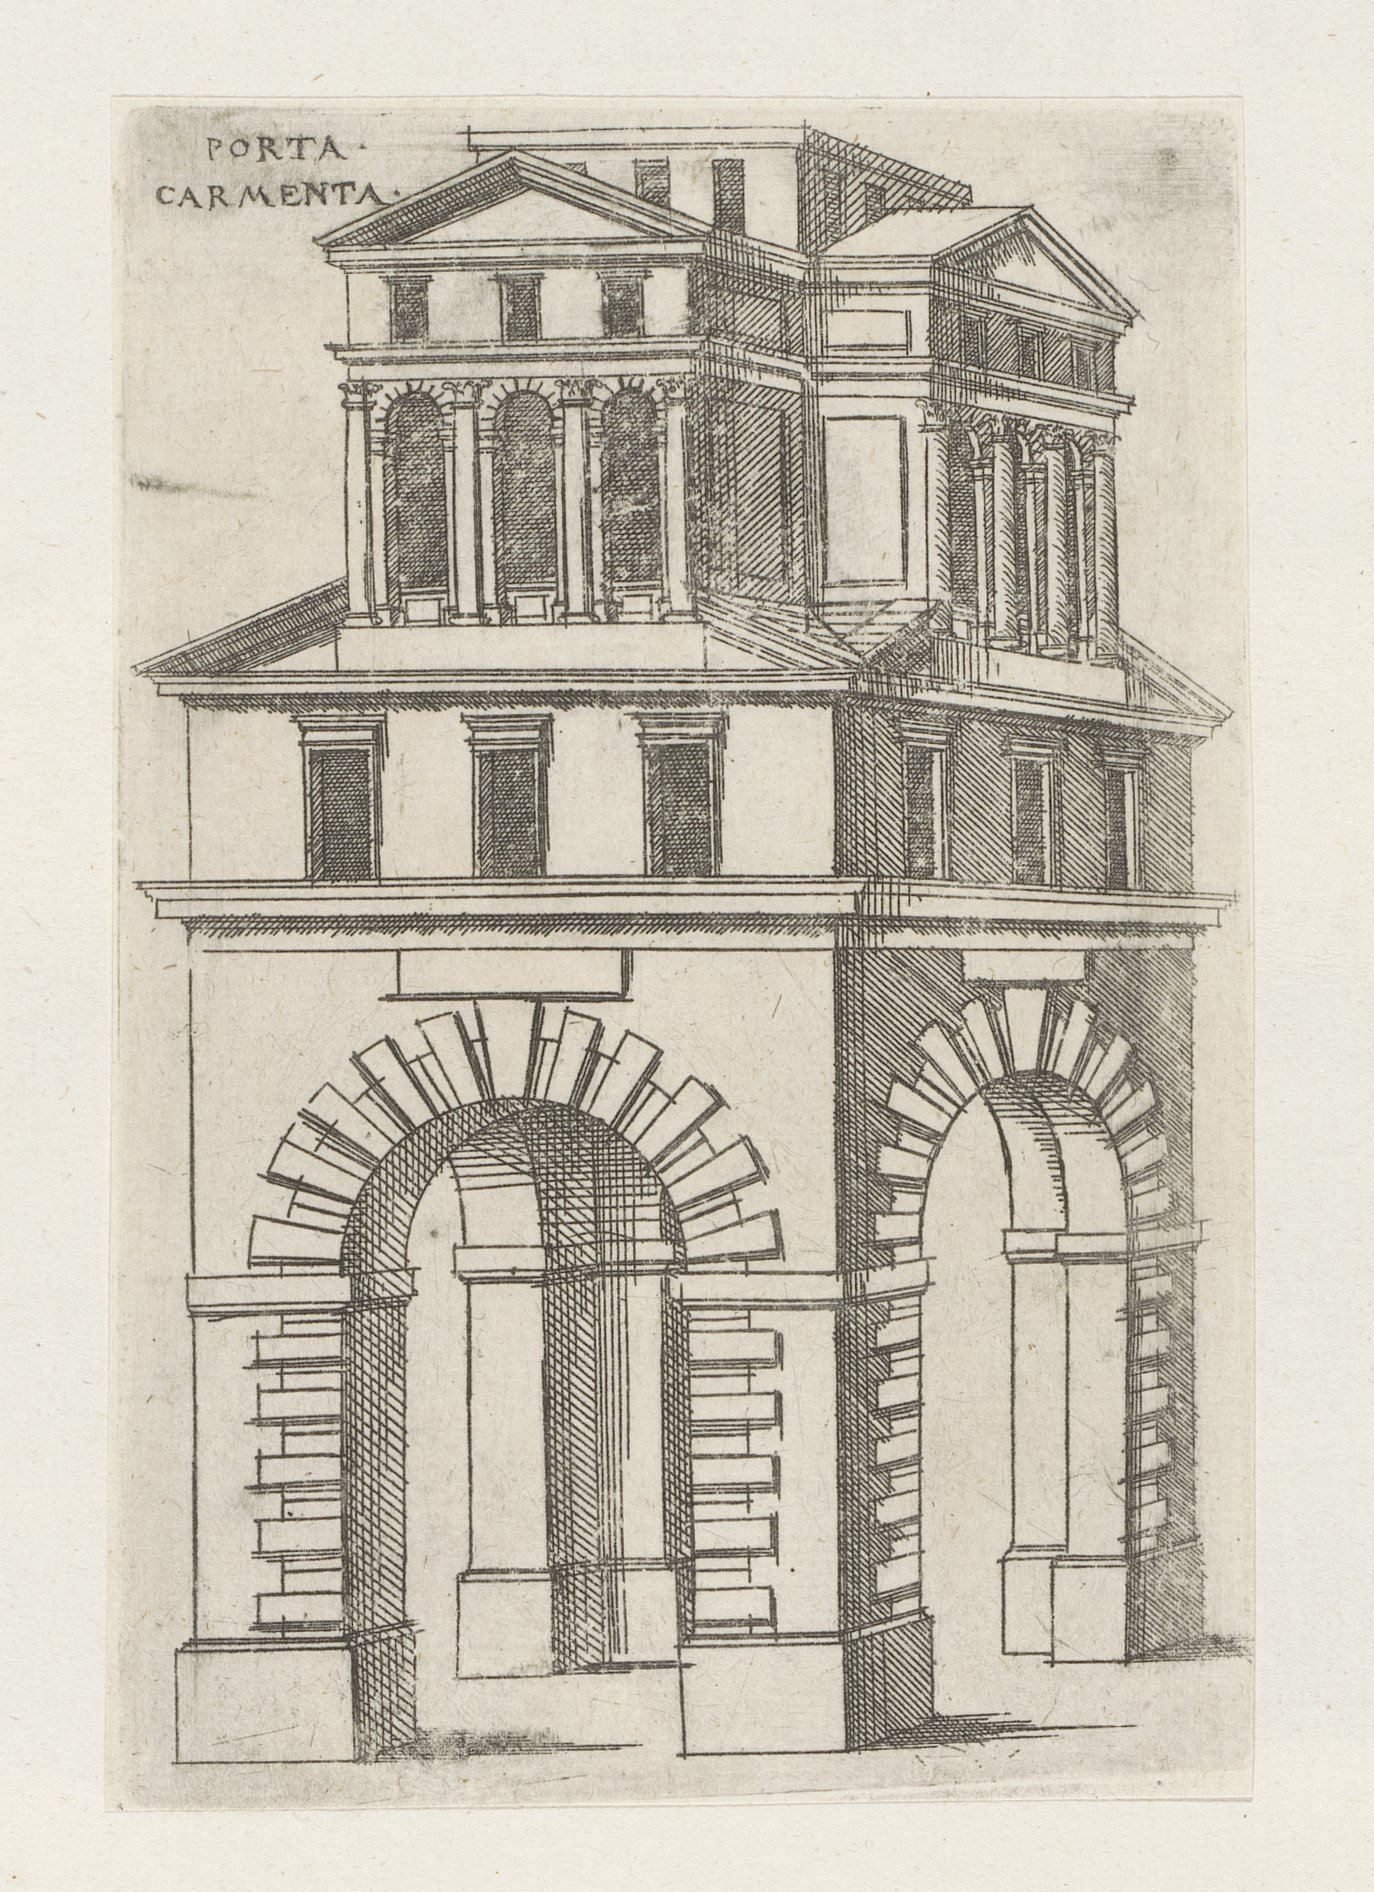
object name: album leaf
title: Magesyn der Italiaense gebouwen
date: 1584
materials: paper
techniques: etching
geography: paris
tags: city-gate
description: Deze prent maakt deel uit van een serie van 98 prenten gedrukt op 48 bladen. De bladen zijn verknipt en een selectie van de losse prenten is in dit album geplakt.